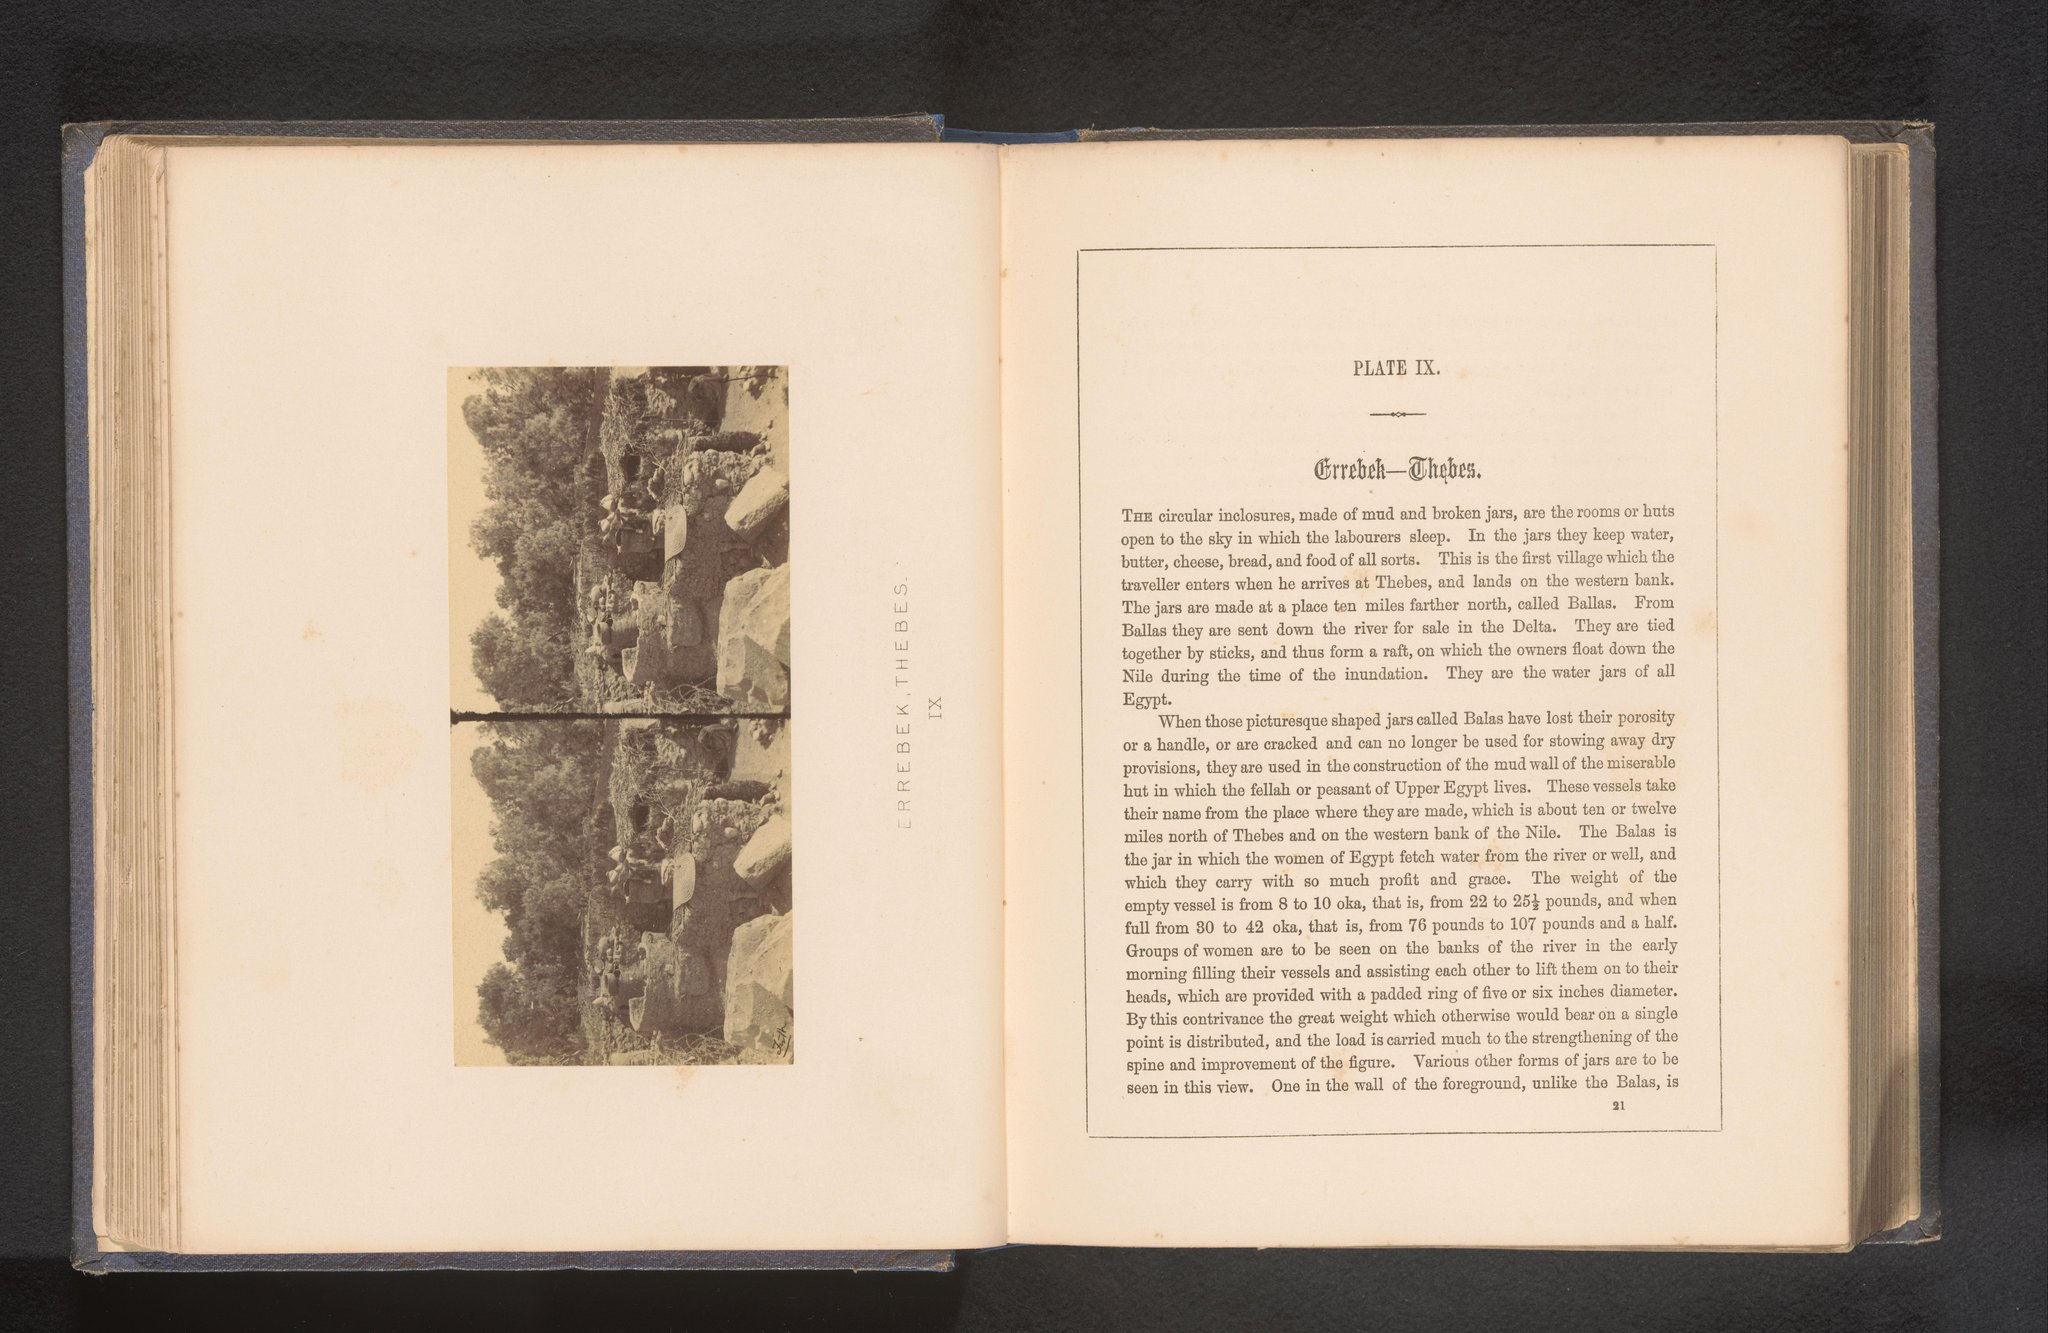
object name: page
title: Errebek, Thebes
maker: francis frith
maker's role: publisher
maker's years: 1822-1898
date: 1857-1862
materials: photographic support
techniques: albumen print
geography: dendera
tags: temple, shrine ~ egyptian religion, thebes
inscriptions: name: ‘Frith’, number: ‘IX’